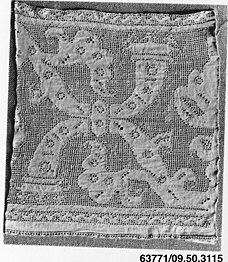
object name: fragment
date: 1601-1700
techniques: embroidery